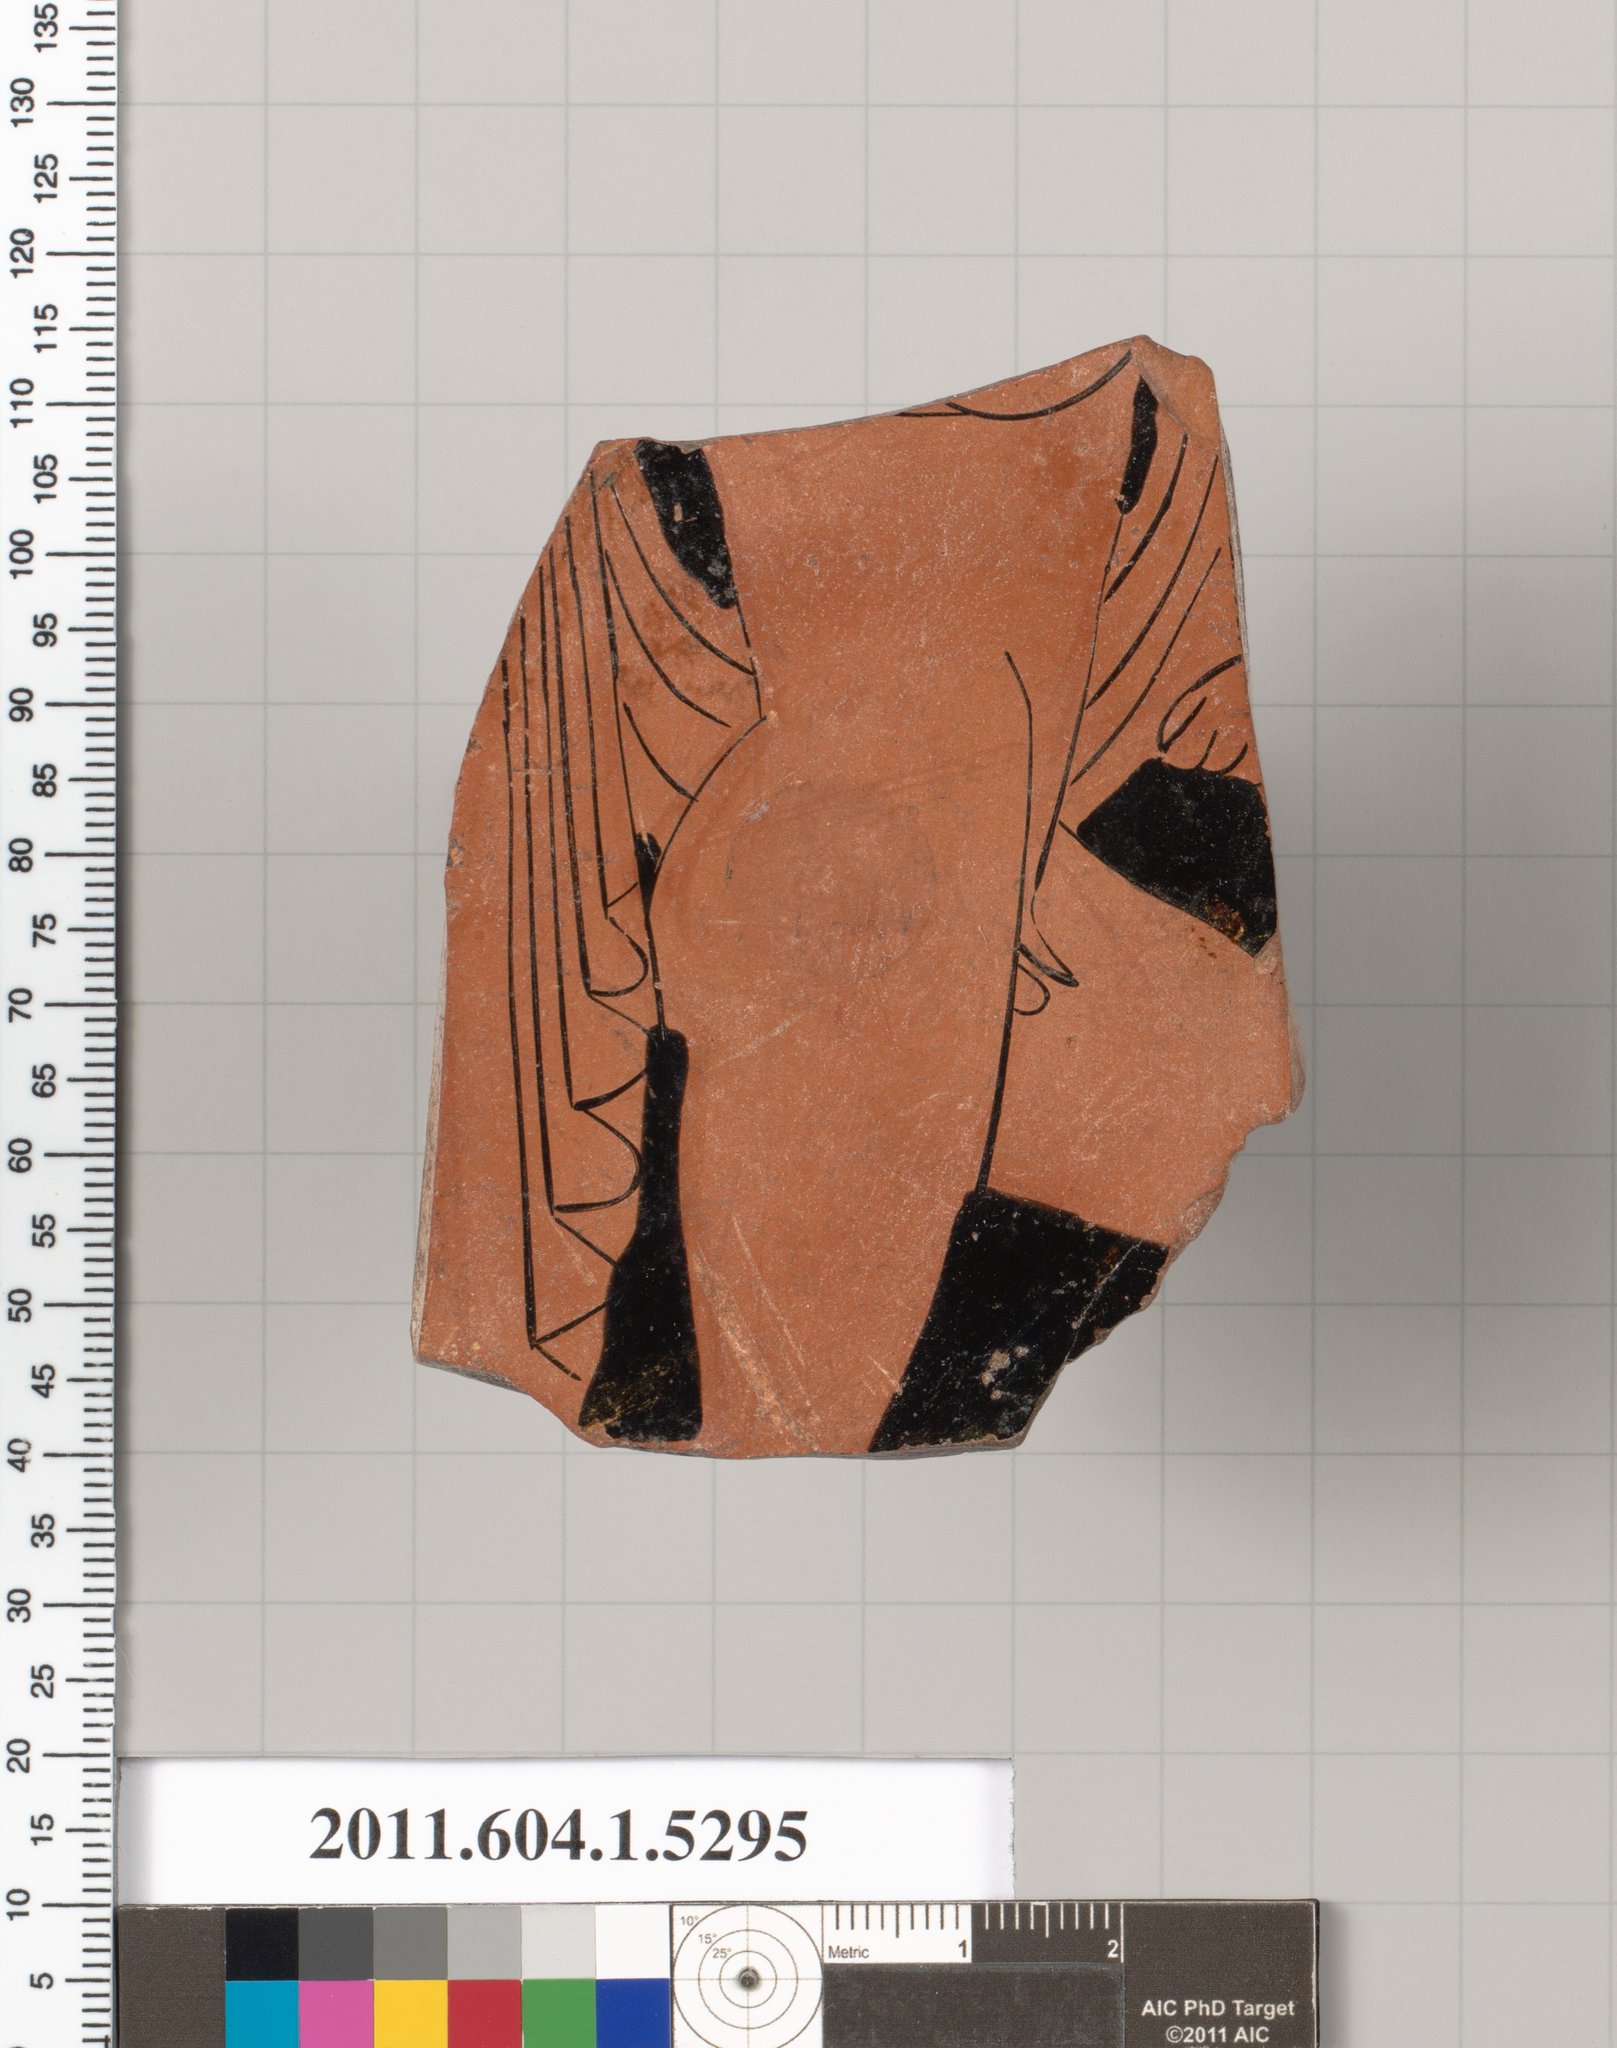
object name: kylix fragment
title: Terracotta fragment of a kylix (drinking cup)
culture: greek, attic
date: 510-490 BCE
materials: terracotta